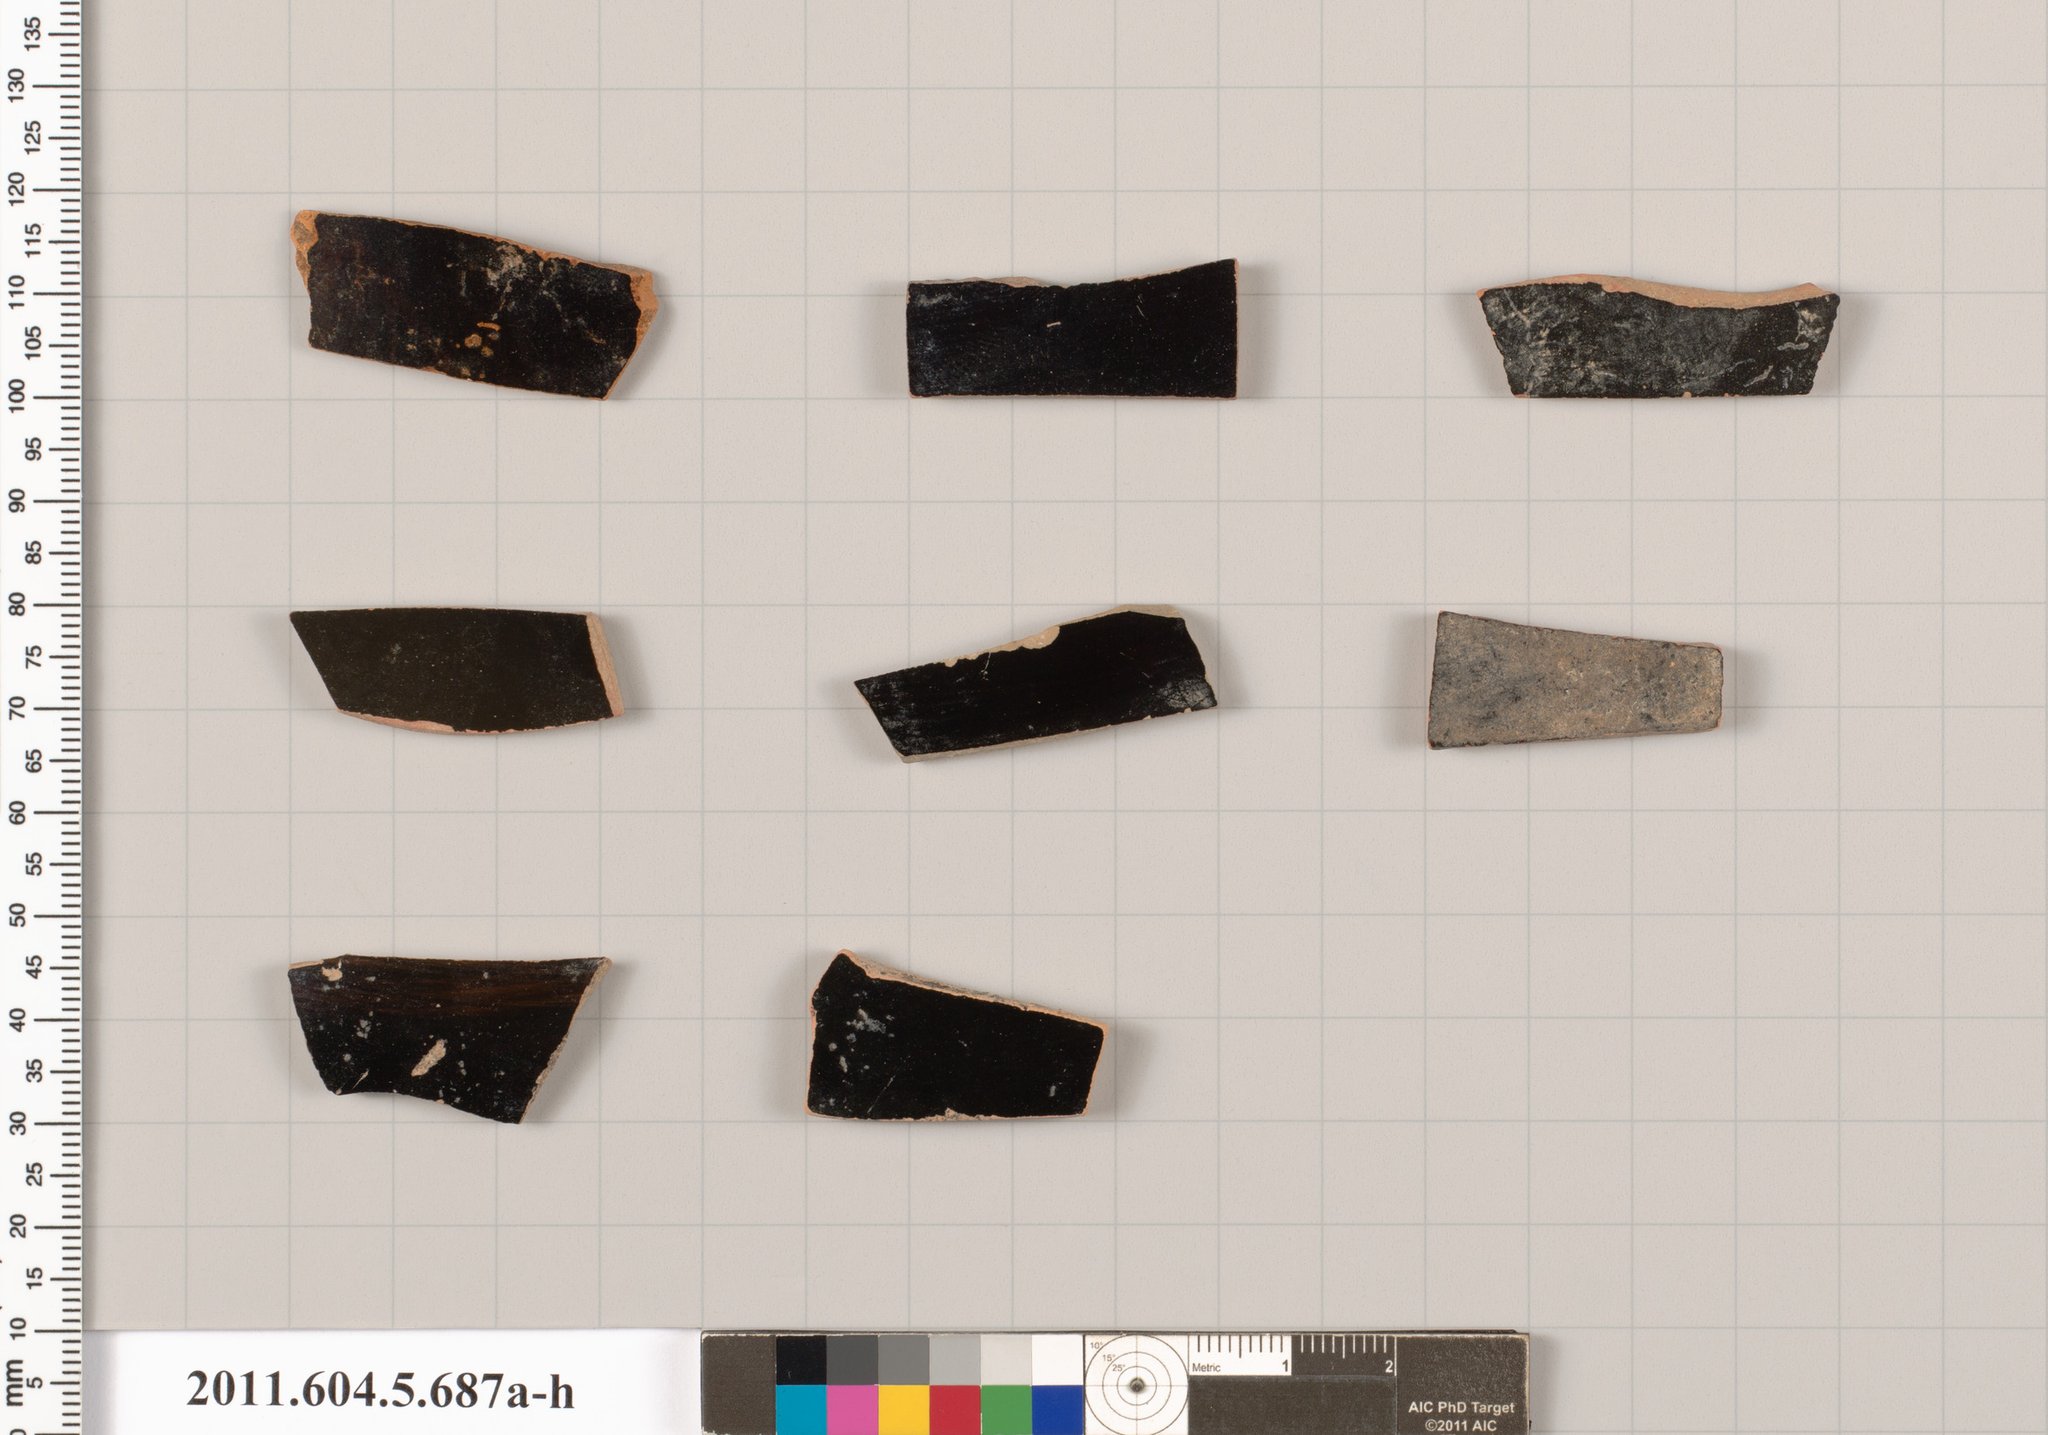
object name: kylix fragment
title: Terracotta fragments of kylikes (drinking cups)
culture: greek, attic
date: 600-401 BCE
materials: terracotta